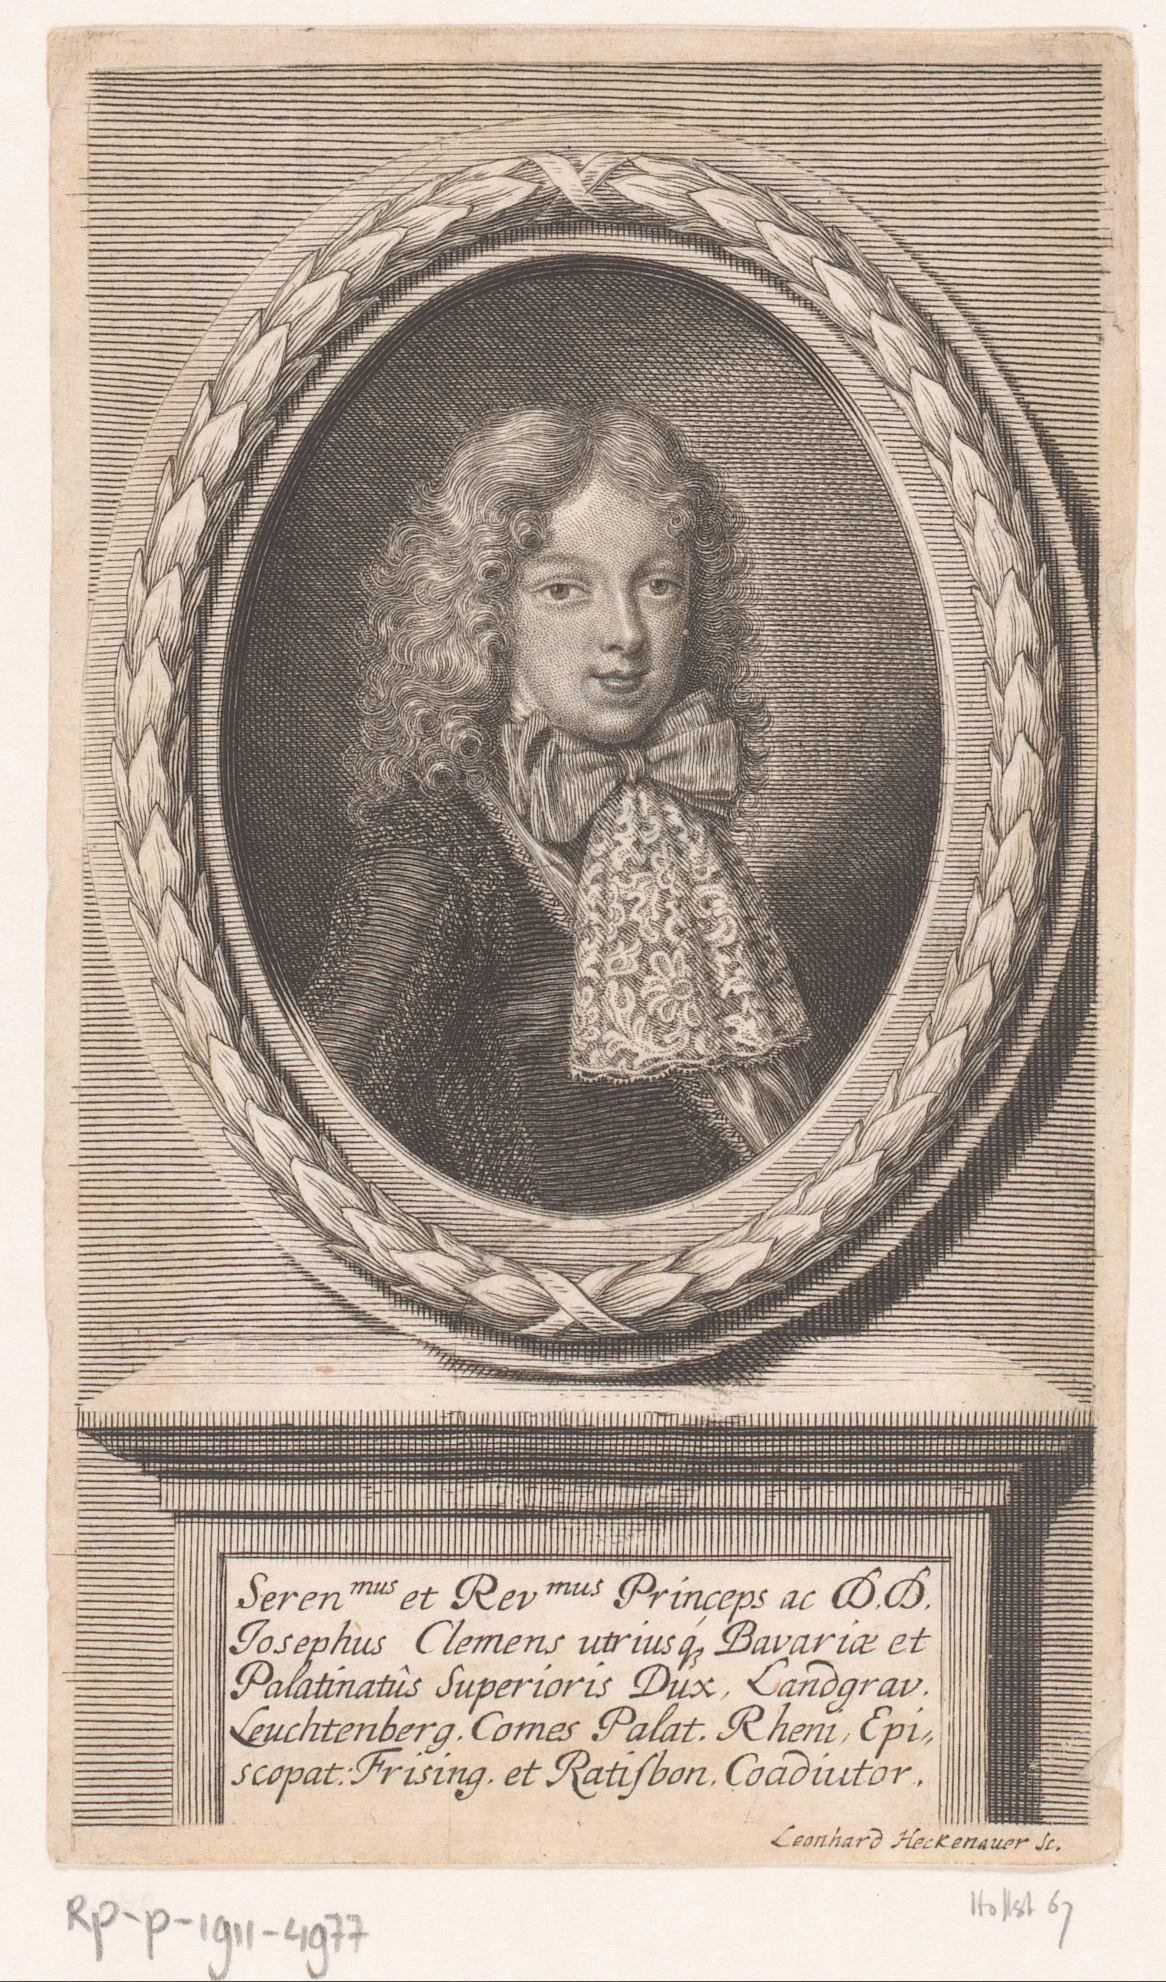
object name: print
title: Portret van Jozef Klemens van Beieren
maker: leonhard heckenauer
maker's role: print maker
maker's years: 1650-1704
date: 1681-1704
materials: paper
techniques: engraving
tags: priest, trees: laurel (branch, stick), historical persons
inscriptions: collector's mark: Lugt 2228